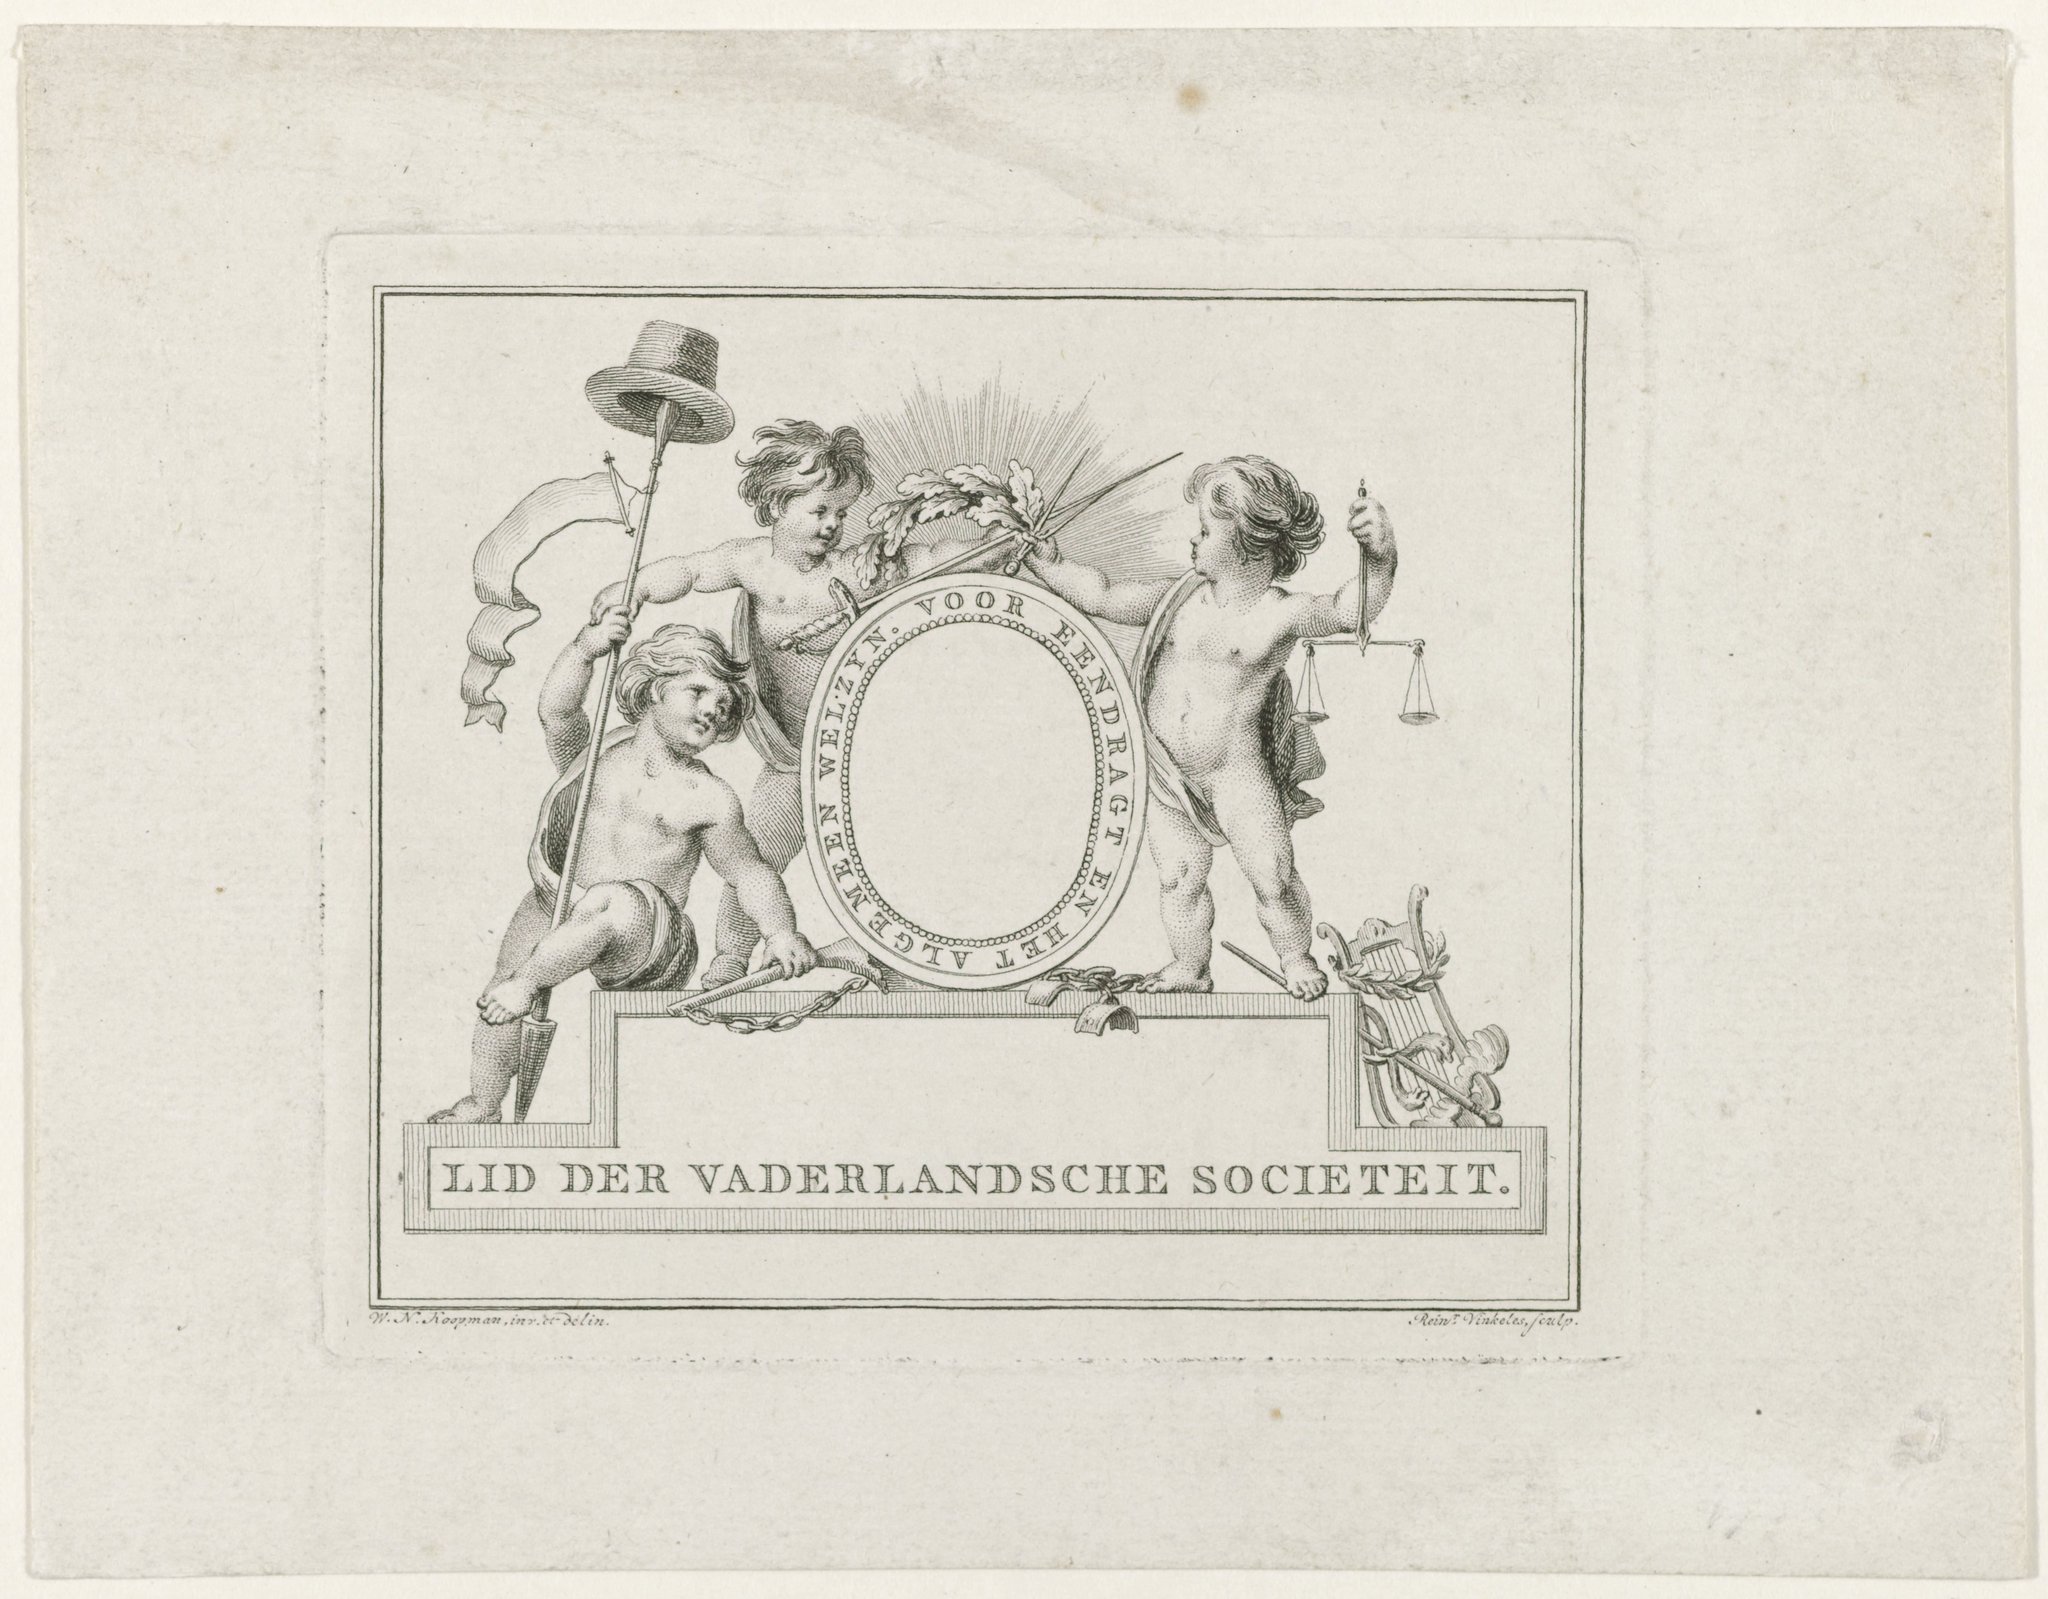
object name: membership certificate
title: Lidmaatschapskaart voor de Vaderlandsche Sociëteit te Utrecht, 1795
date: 1795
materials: paper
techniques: engraving, etching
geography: northern netherlands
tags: utrecht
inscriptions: collector's mark: Lugt 2228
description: Proefdruk van een lidmaatschapskaart voor de Vaderlandsche Sociëteit te Utrecht, opgericht 1795. Drie putti rond een medaillon met de zinspreuk "Voor Eendragt en het Algemeen Welzyn". De putti dragen als attributen de speer met vrijheidshoed, weegschalen van de Rechtvaardigheid en zwaard met krans van eikenbladeren.